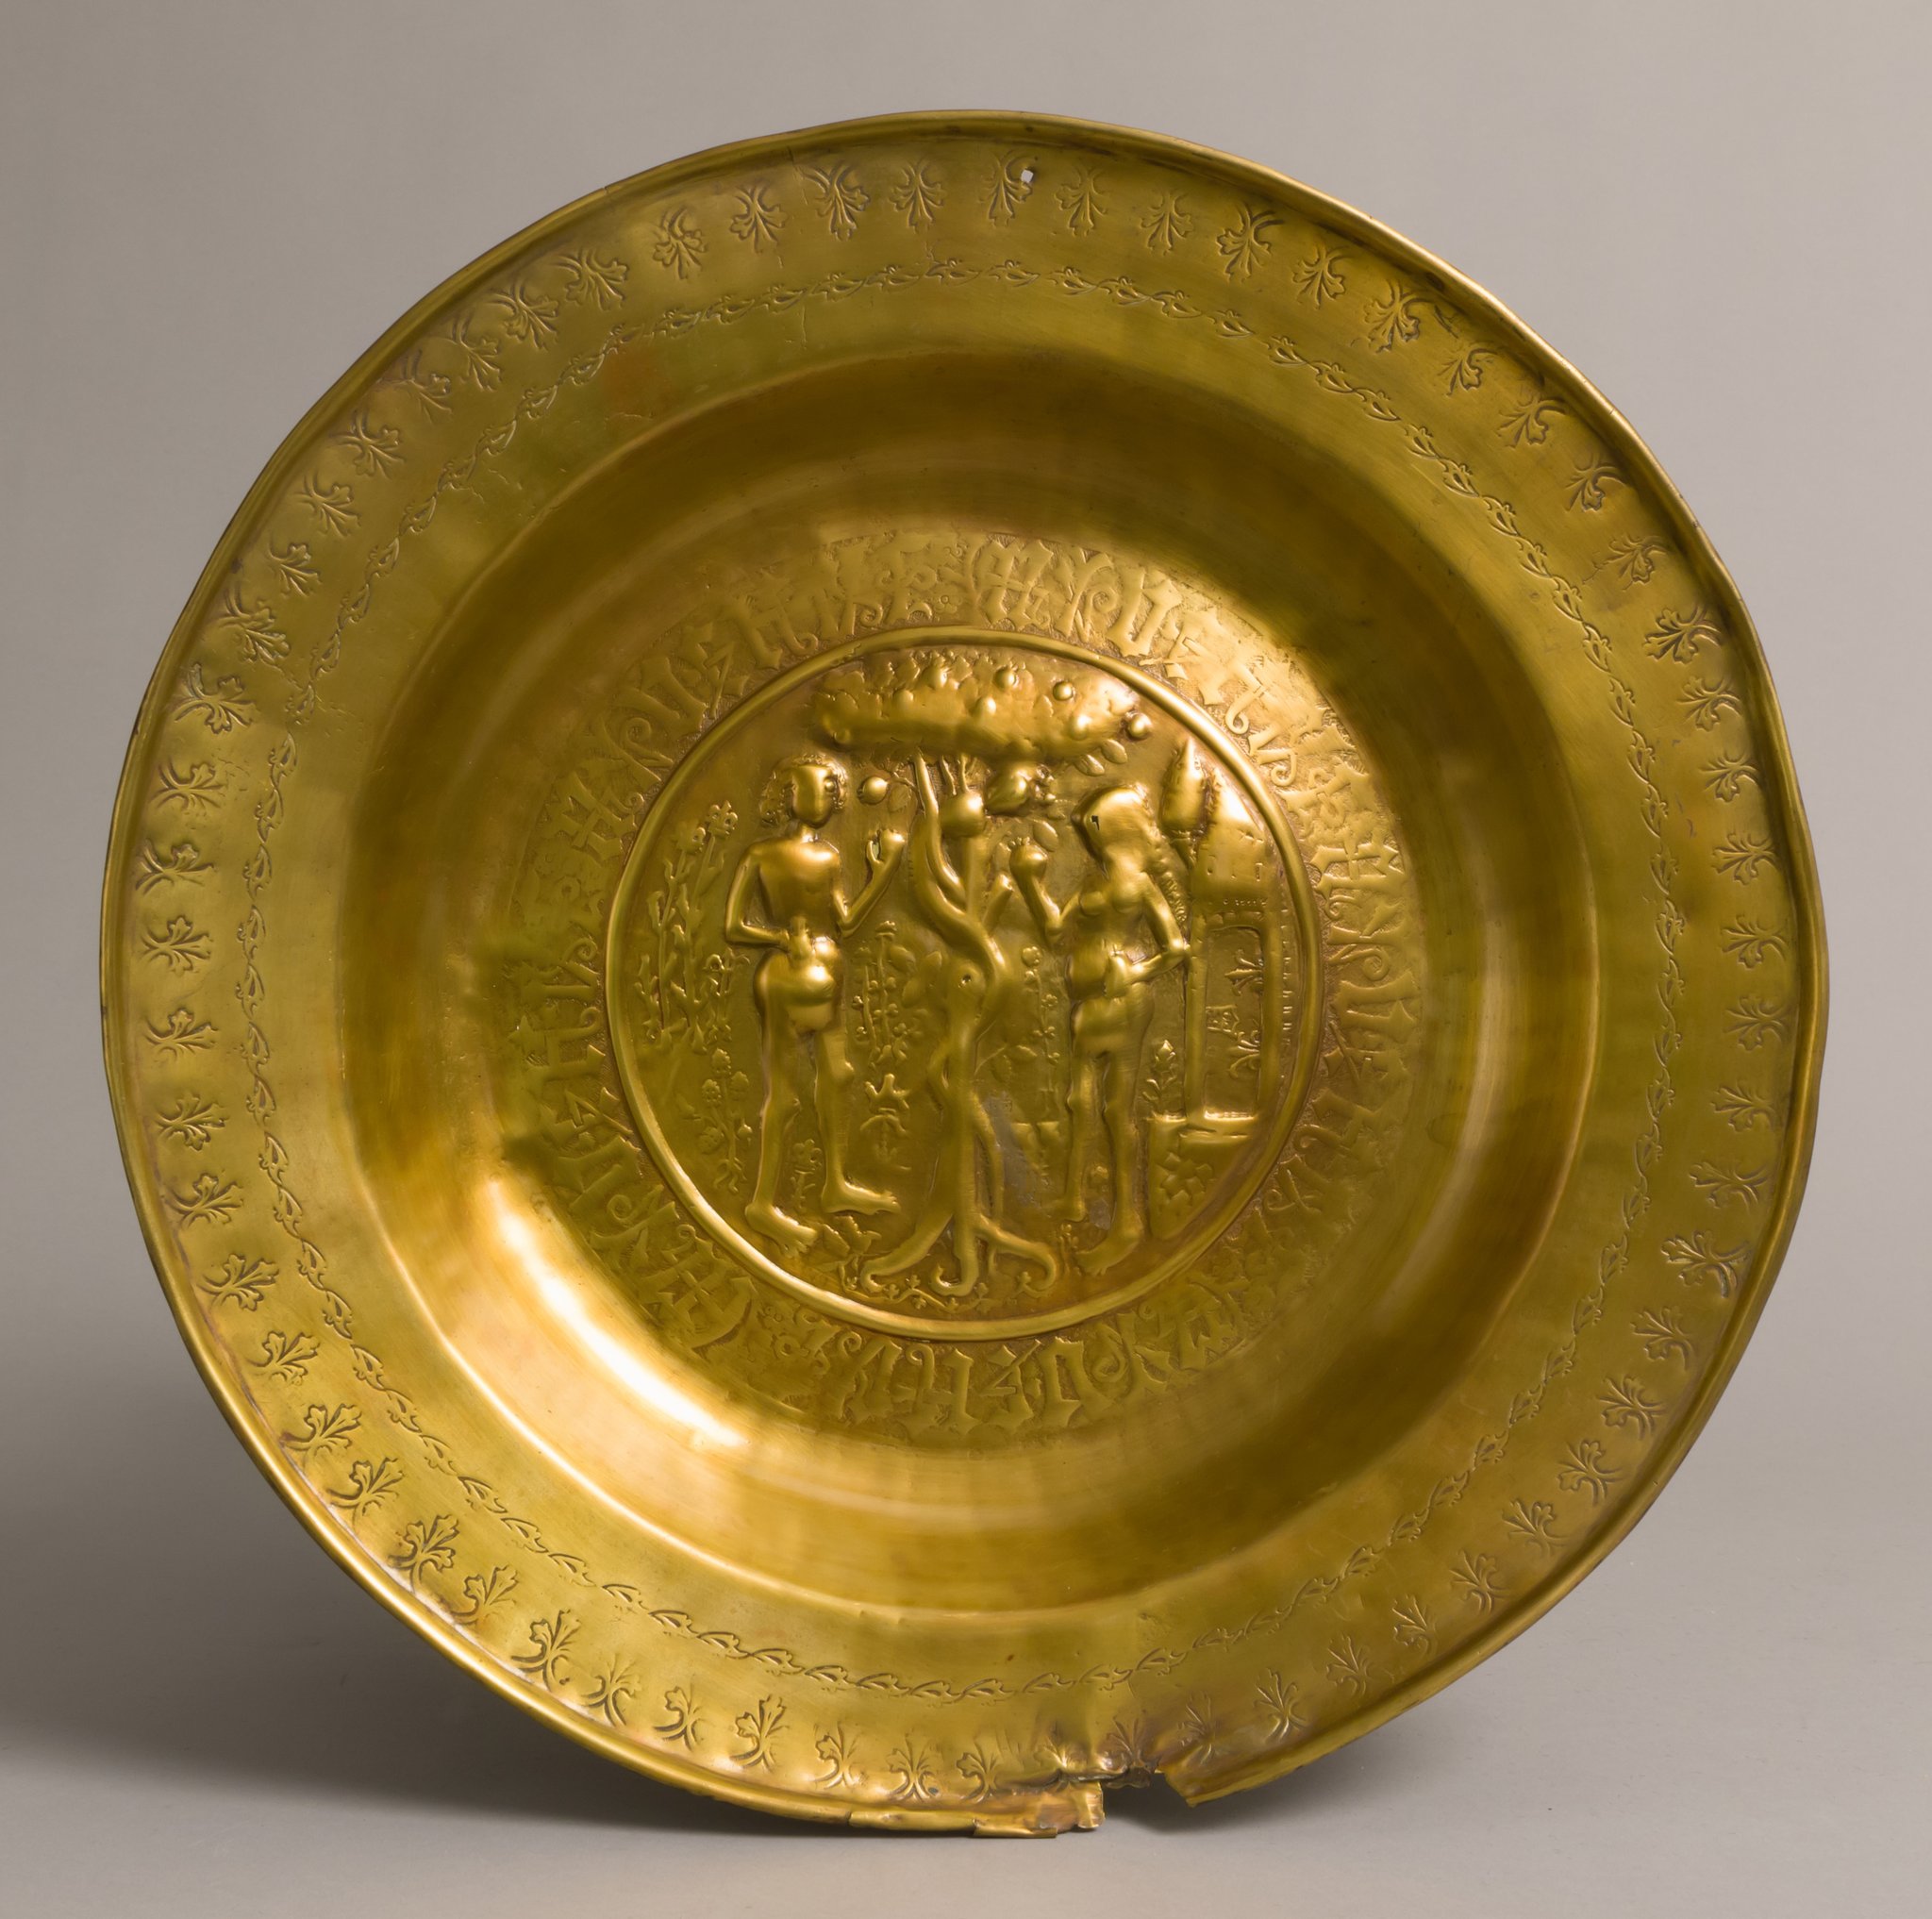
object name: dish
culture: german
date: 1501-1533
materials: brass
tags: men,women